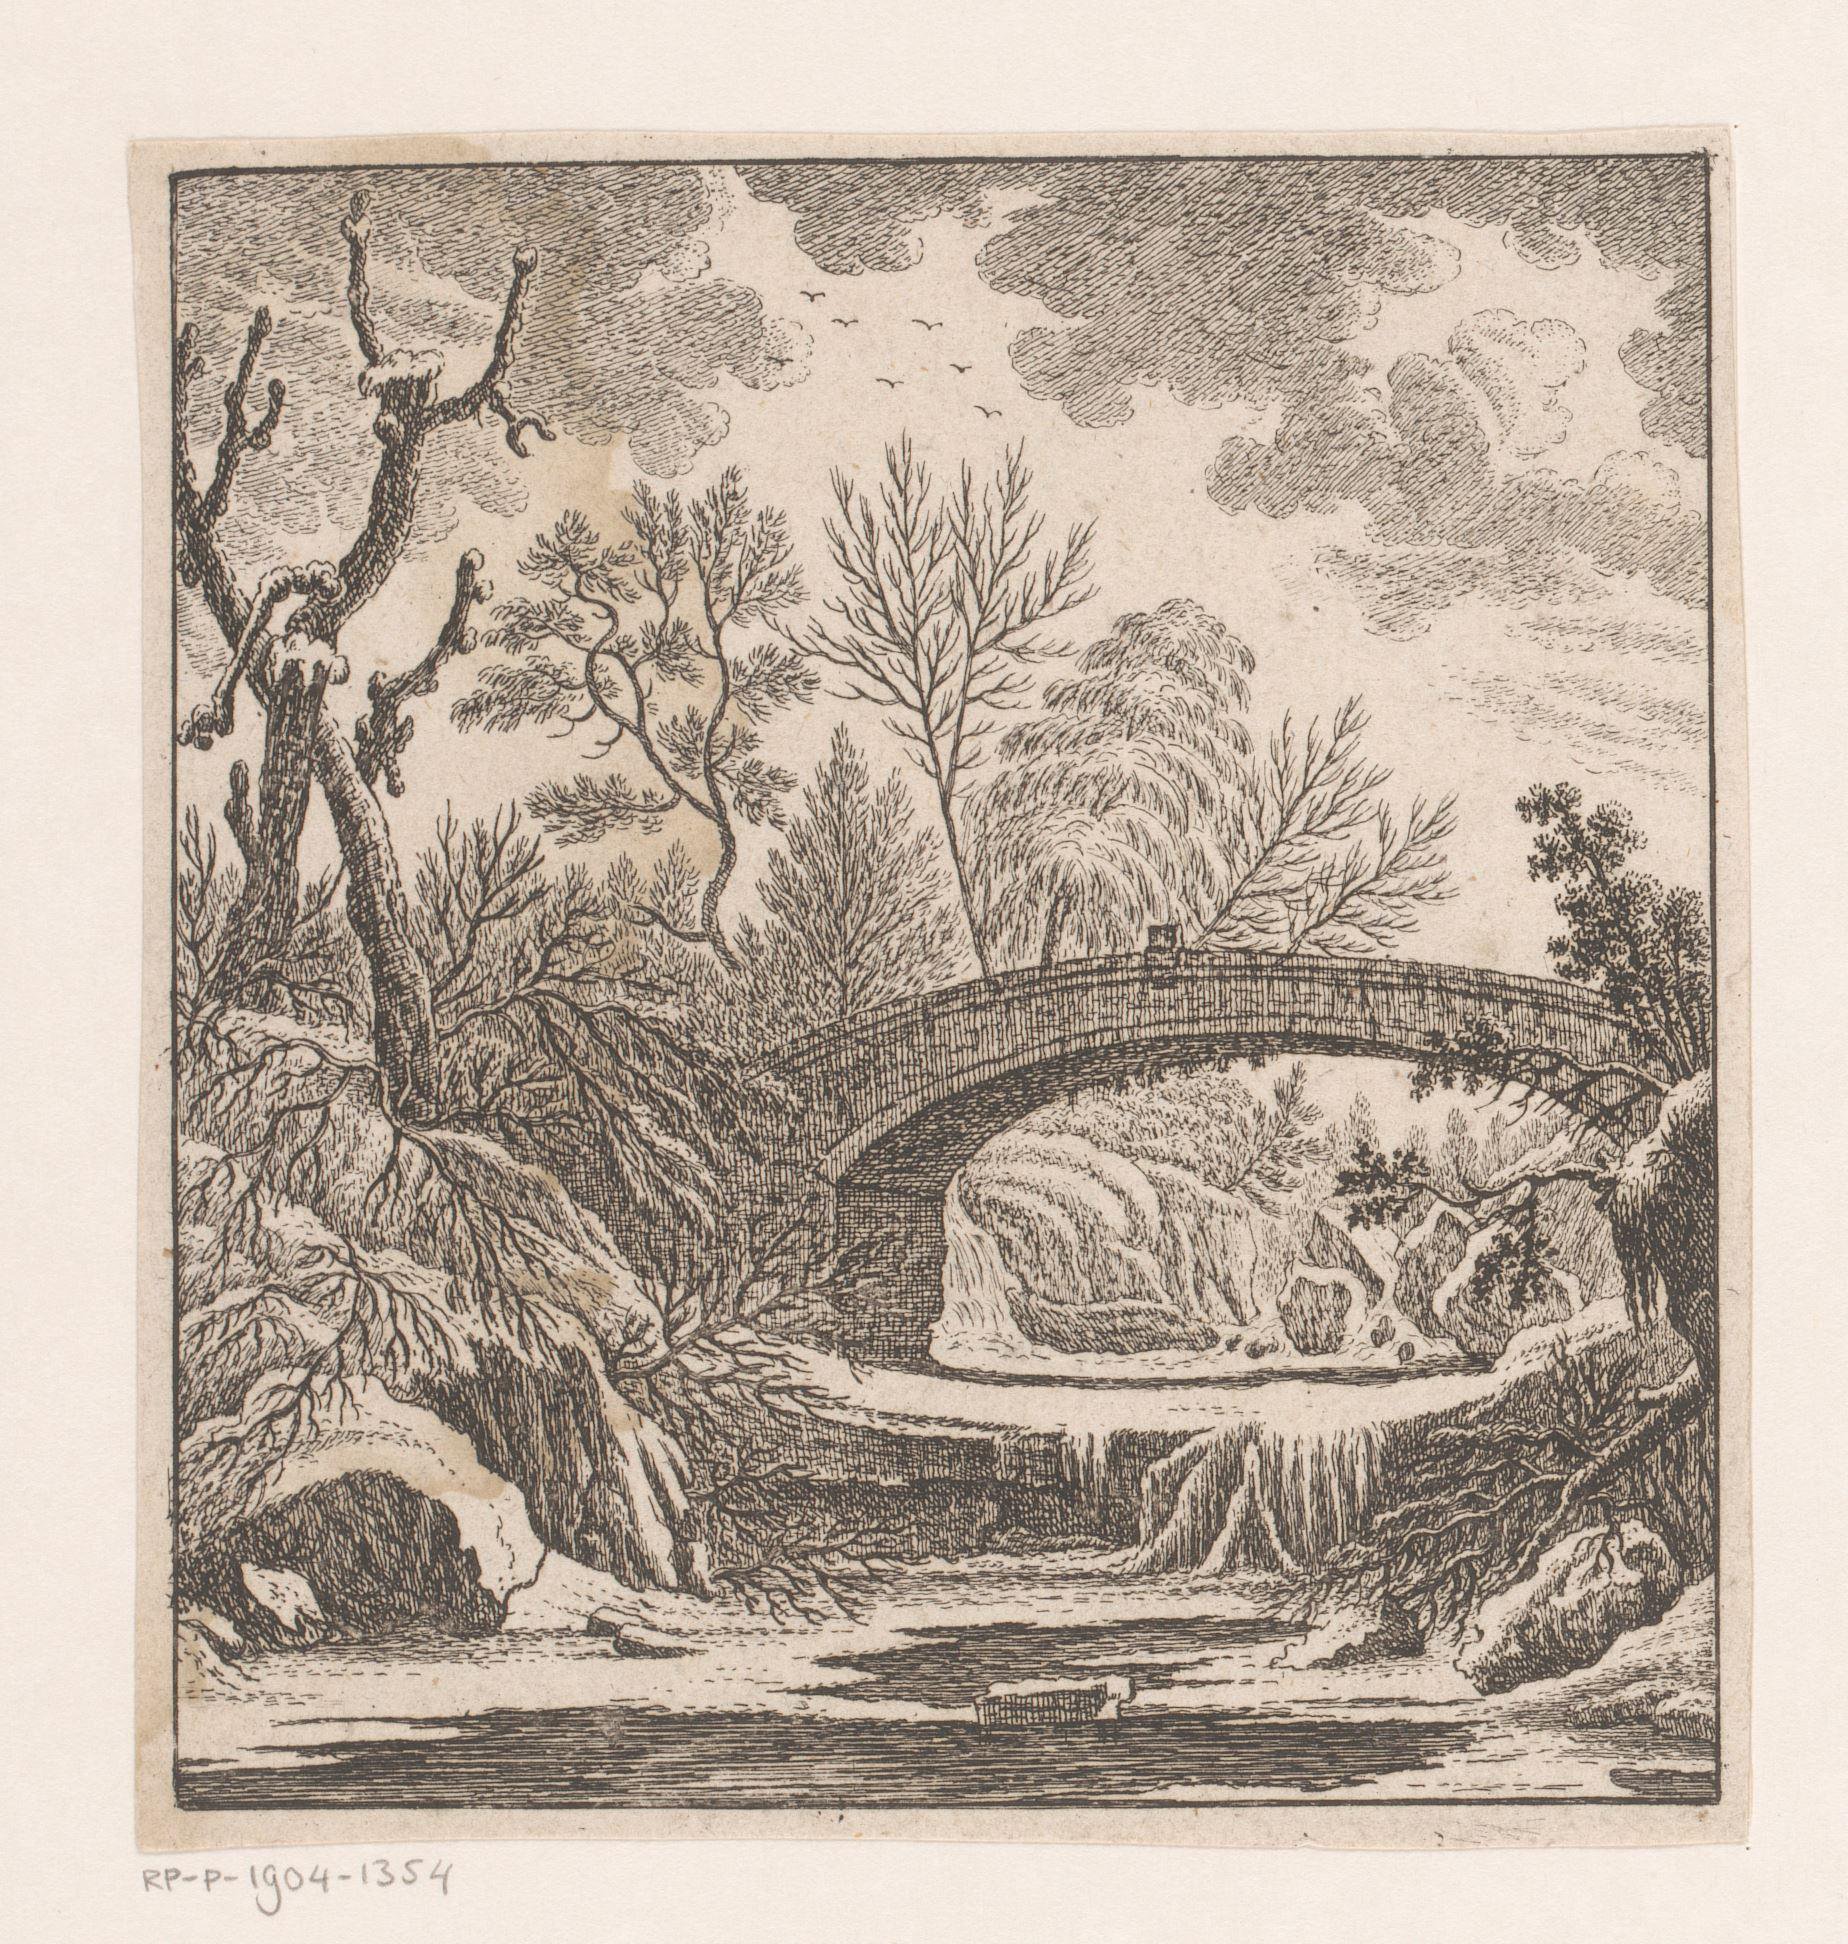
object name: print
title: Landschap met een brug over een bevroren beek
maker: johann caspar ulinger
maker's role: painter, print maker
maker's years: 1703-1768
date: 1713-1768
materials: paper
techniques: etching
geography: switzerland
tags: landscape with bridge, viaduct or aqueduct, landscapes with waters, waterscapes, seascapes (in the temperate zone), ice ~ freezing weather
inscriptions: collector's mark: Lugt 2228